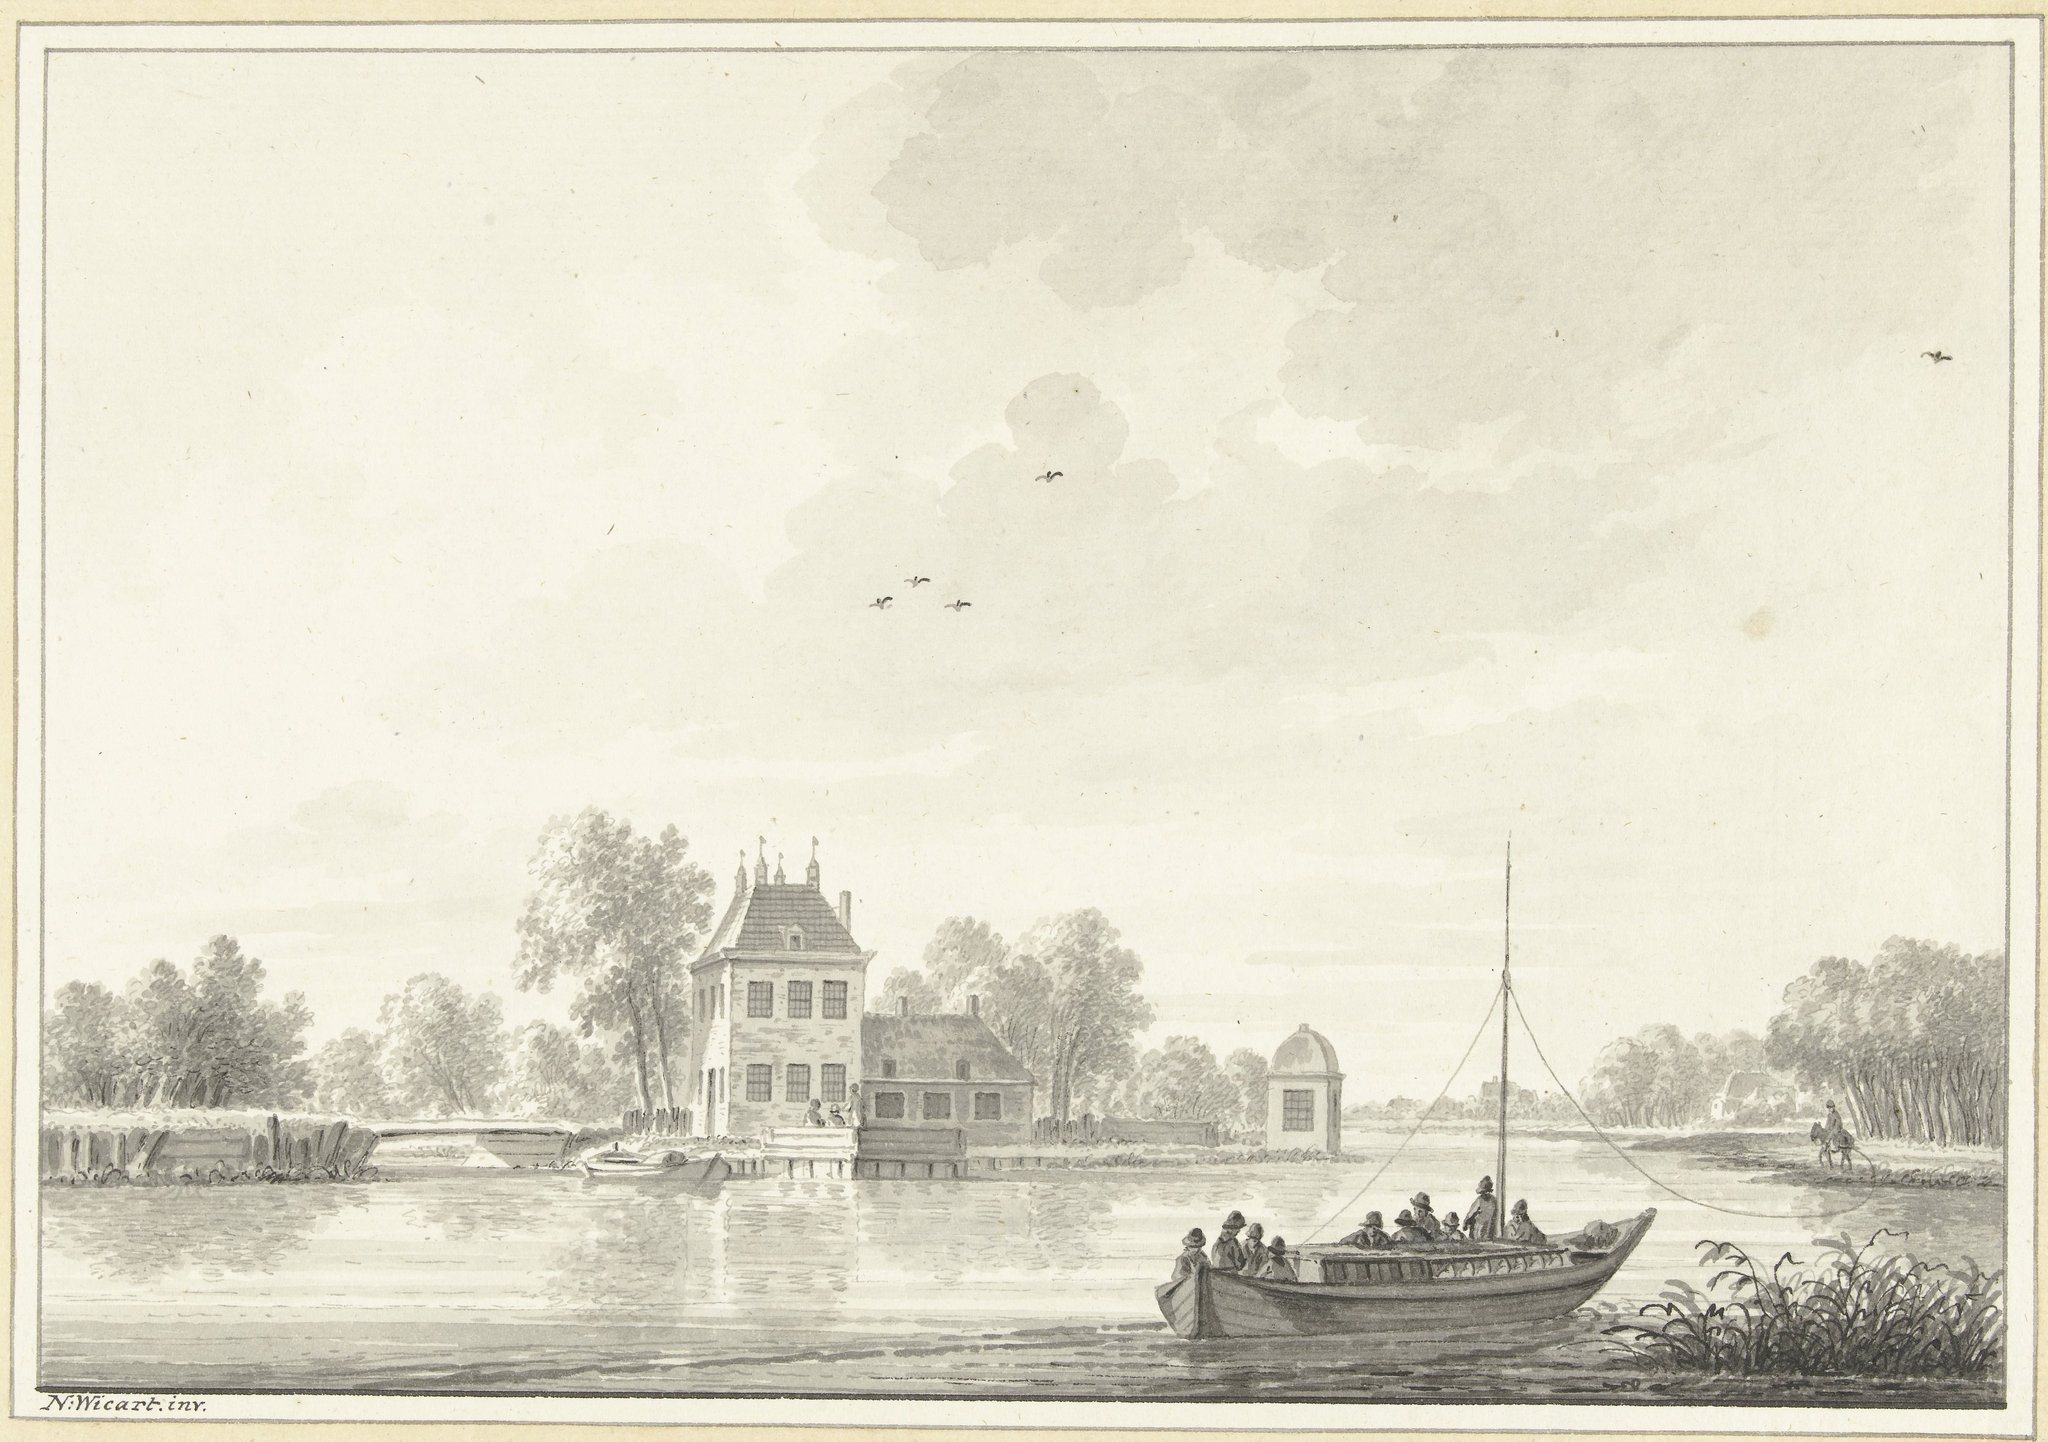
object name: drawing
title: Gezicht op een buitenplaats aan de Vecht tussen Maarssen en Breukelen, met trekschuit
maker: nicolaas wicart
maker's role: draughtsman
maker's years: 1748-1815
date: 1758-1815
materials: ink, paper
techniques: brush, pen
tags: maarssen, vecht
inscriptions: inscription: ‘Tusschen Maarsen en Breukelen 1791’